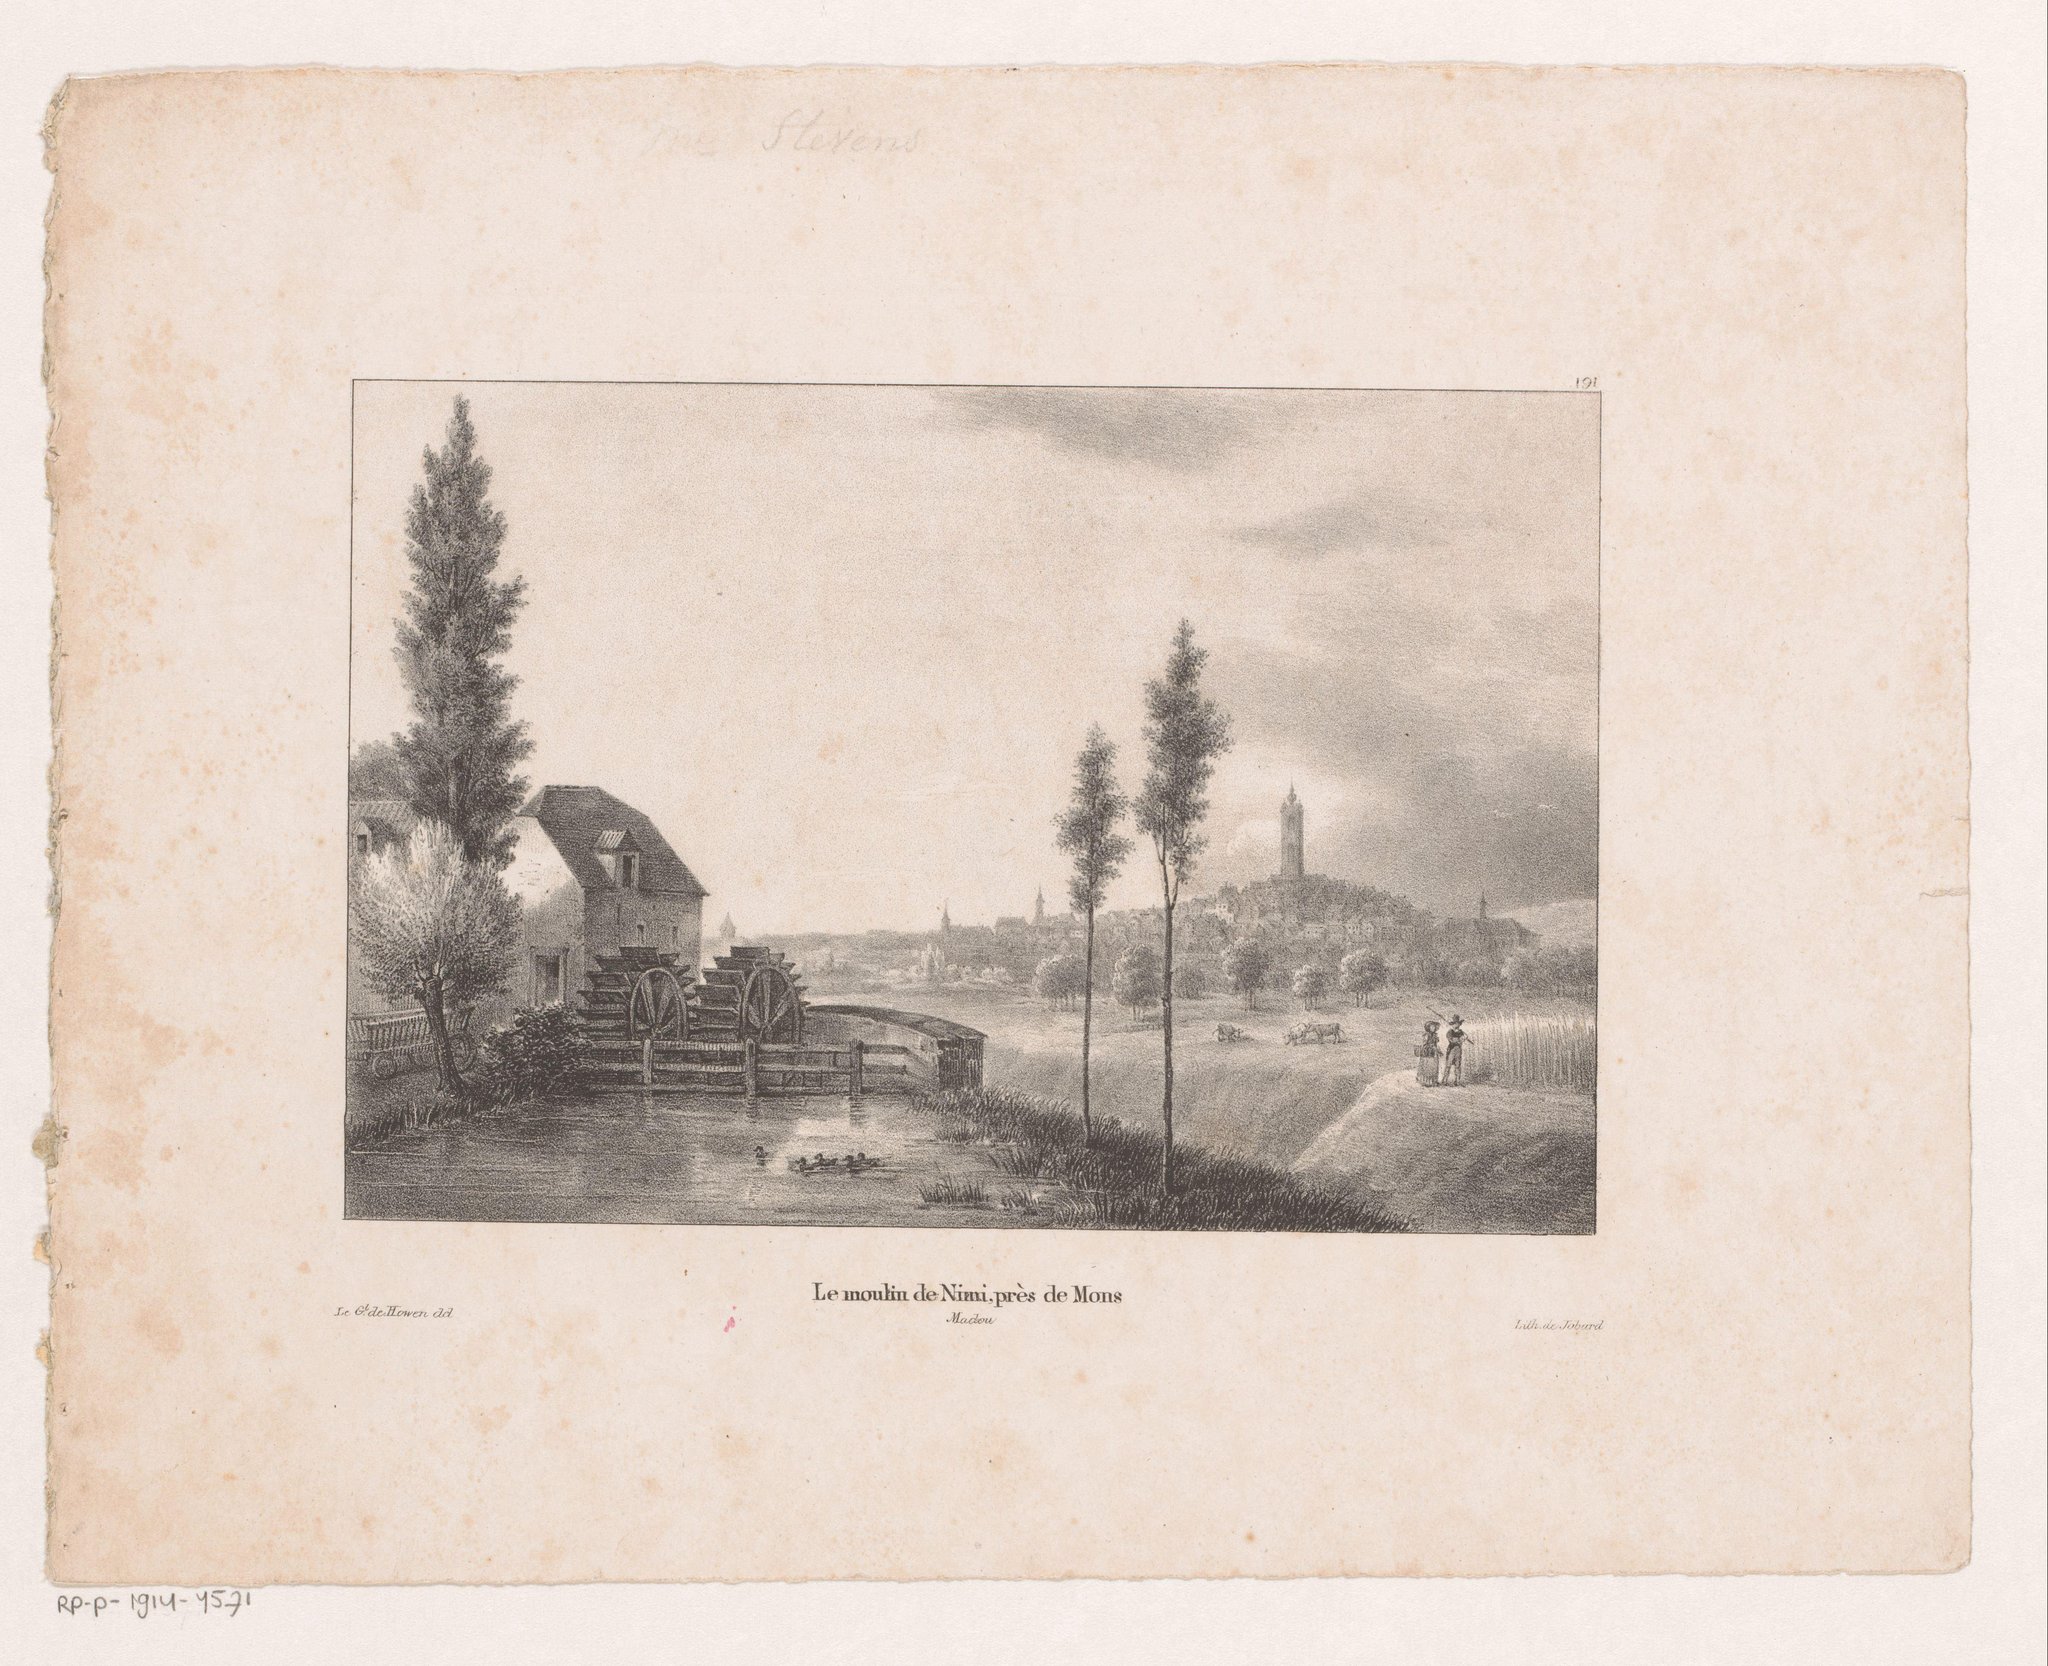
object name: print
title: Le moulin de Nimi, près de Mons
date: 1815-1830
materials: paper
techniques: lithograph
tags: watermill in landscape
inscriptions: collector's mark: Lugt 2228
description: Mogelijk komt deze prent uit: Howen, O. Vues pittoresques des bords de la Meuse : depuis Namur jusqu'à Dinant, du Trou de Han, et des environs de Rochefort / par un officier d'artillerie. Uitgegeven in 1818.